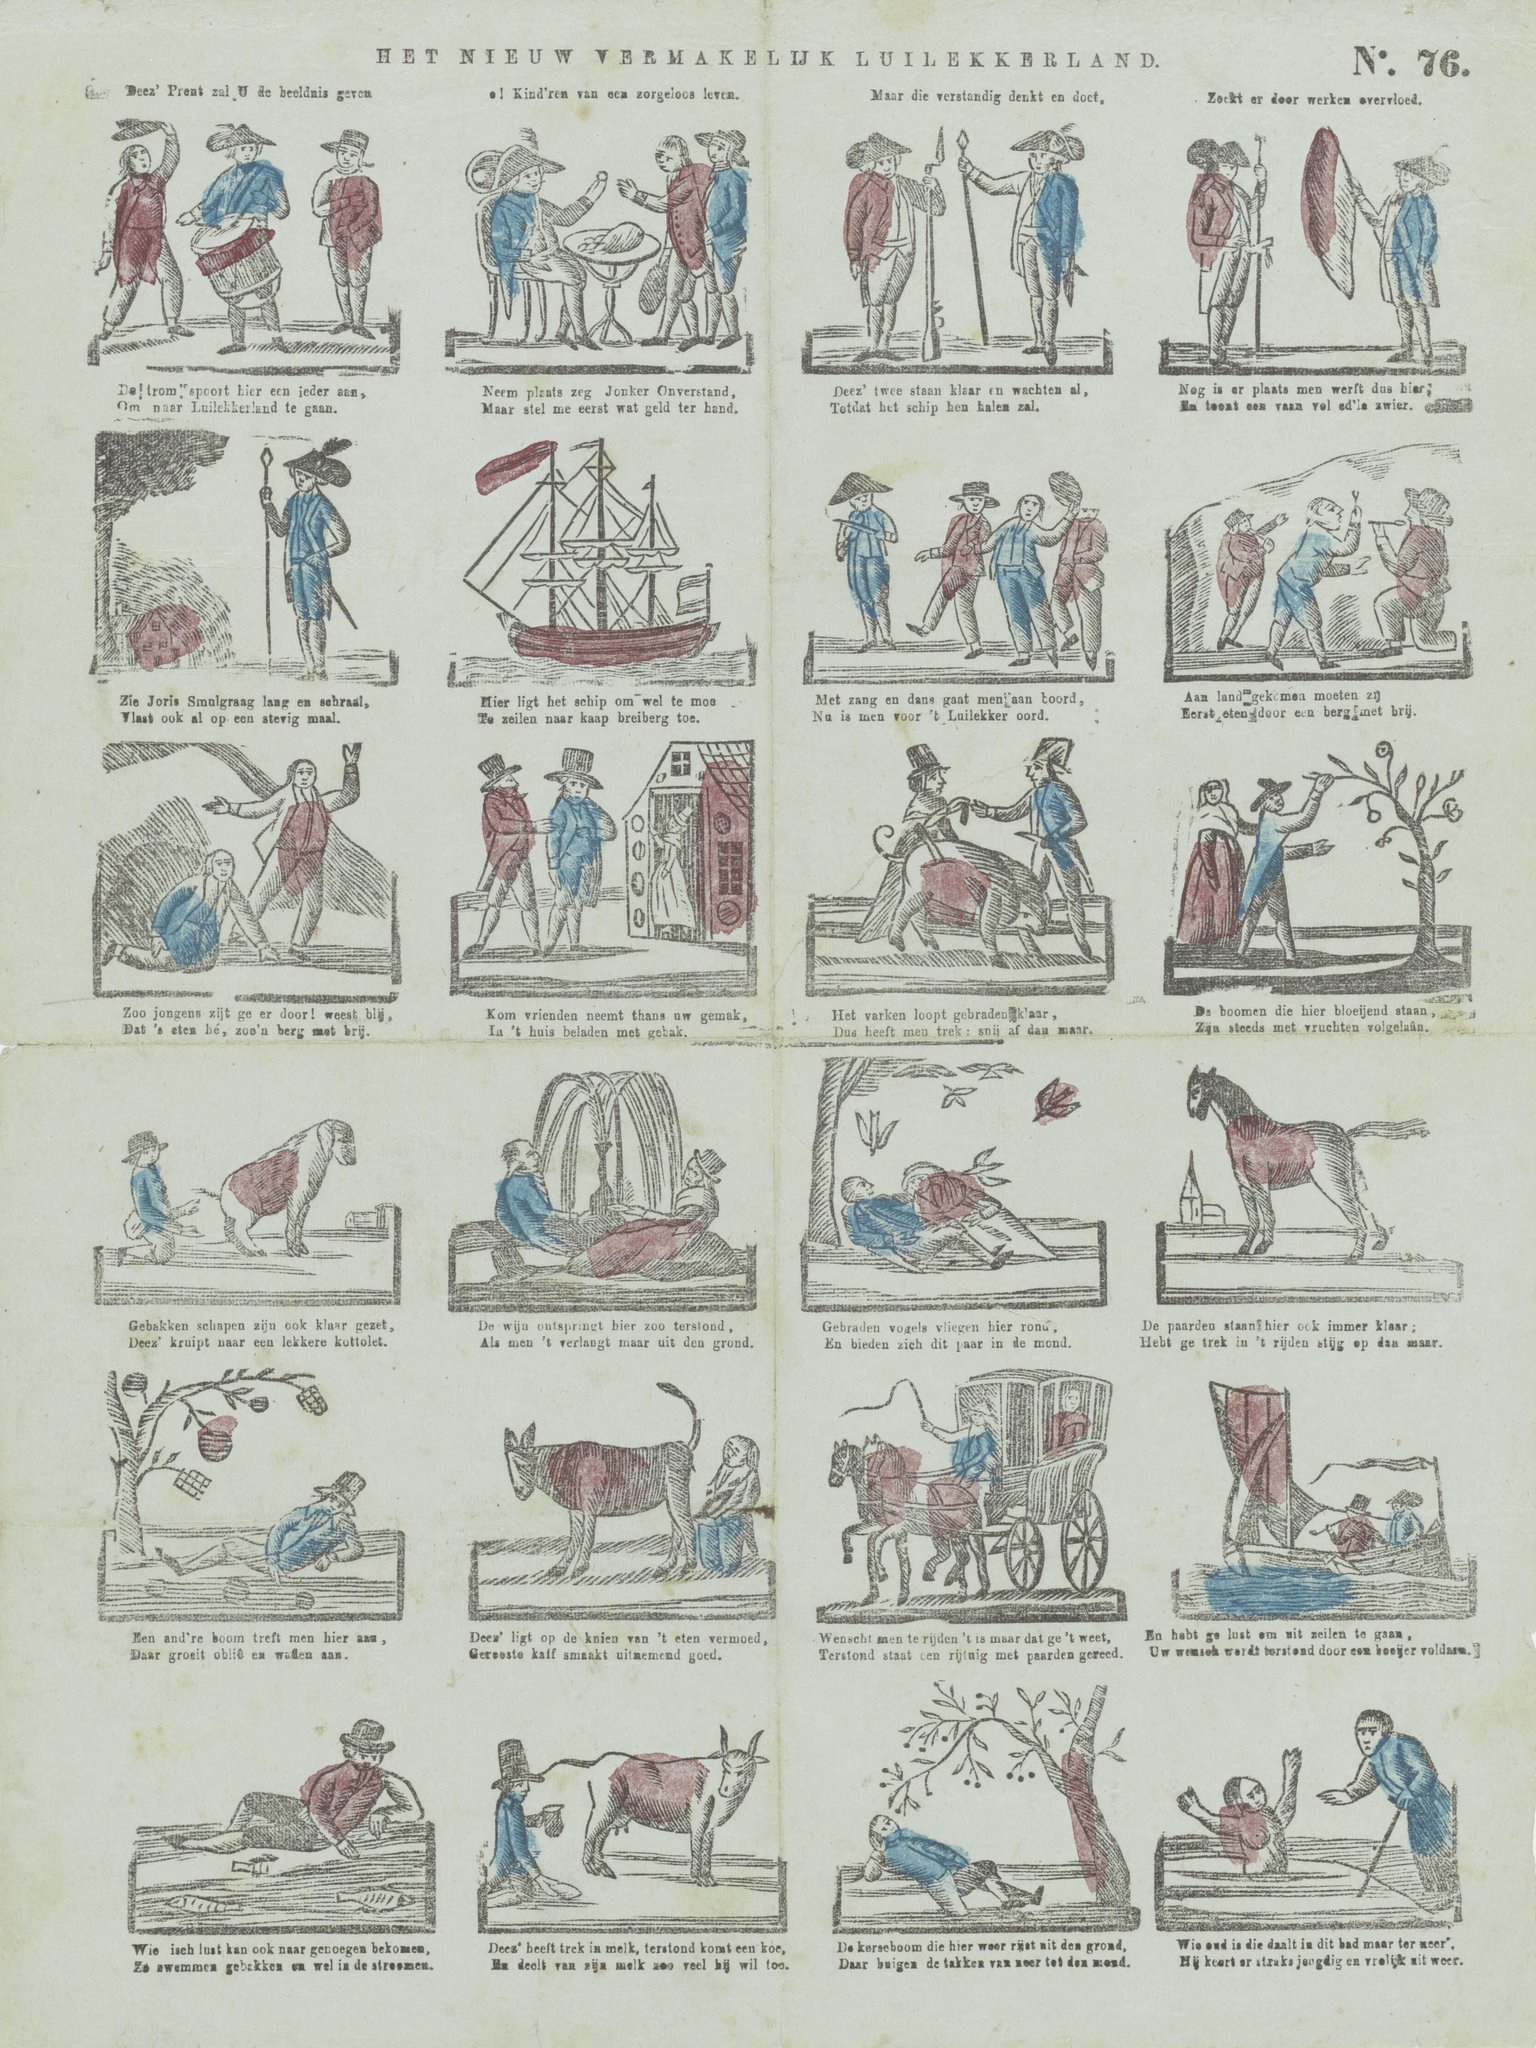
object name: print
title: Het nieuw vermakelijk luilekkerland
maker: Anonymous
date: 1850-1870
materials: paper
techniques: colour, letterpress printing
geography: netherlands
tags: land of cockaigne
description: Blad met 24 voorstellingen van het Luilekkerland. Onder elke voorstelling een tweeregelig vers. Genummerd rechtsboven: No. 76.